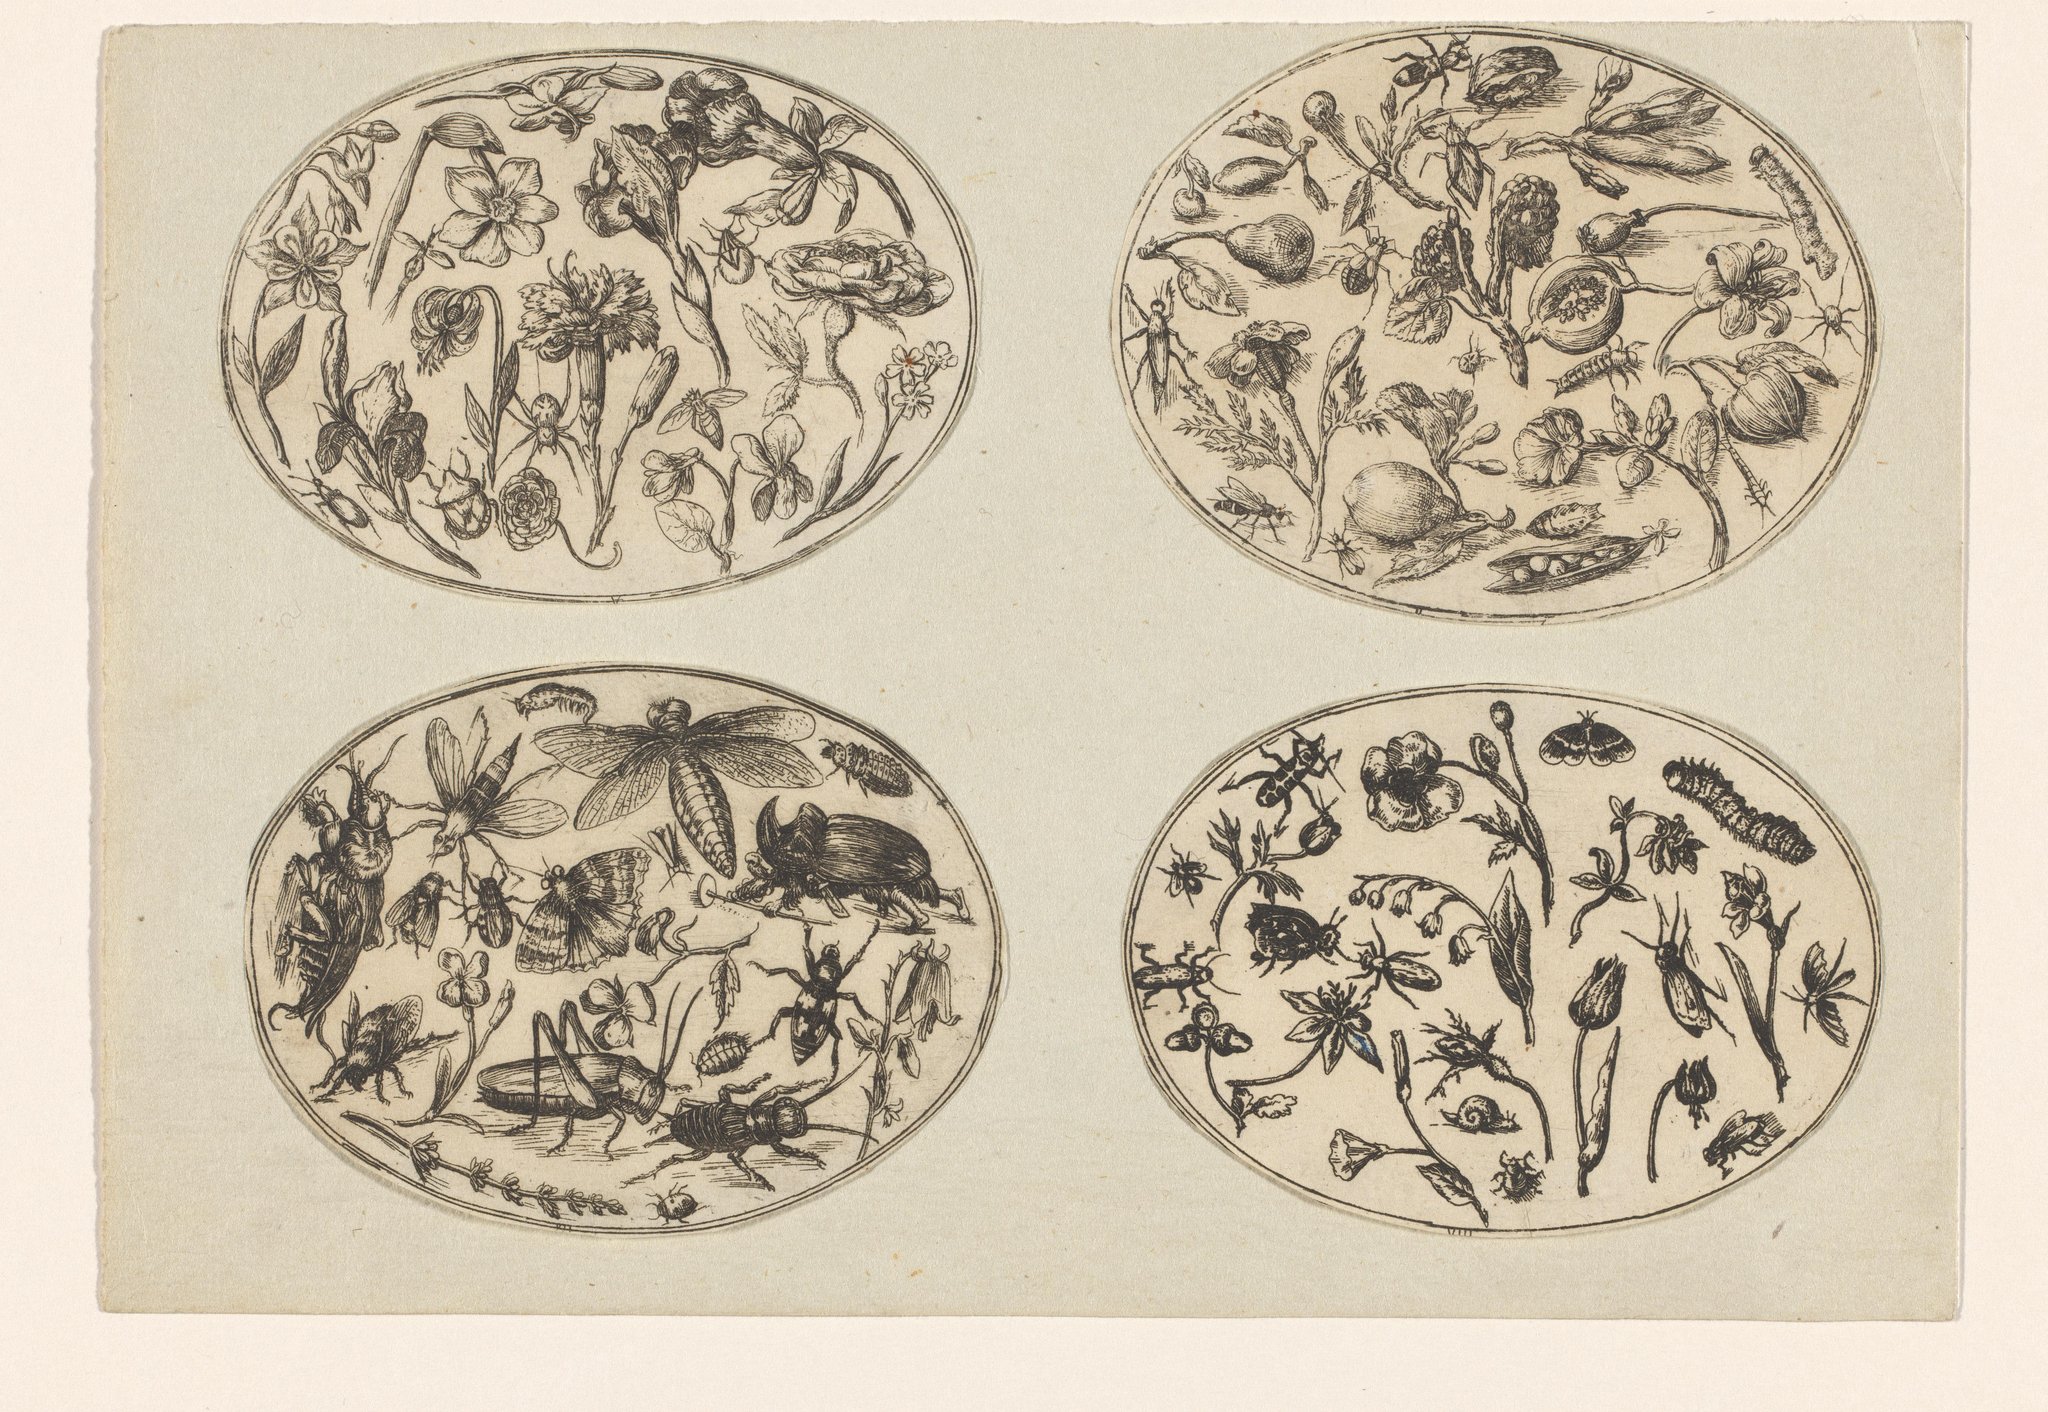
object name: ornament print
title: Vruchten, bloemen, insecten en spinnen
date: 1650-1666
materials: paper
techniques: etching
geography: nuremberg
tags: fruits and vegetables ~ ornament, spiders, insects, flowers ~ ornament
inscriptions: collector's mark: Lugt 2760, collector's mark: Lugt 2228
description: Paul Fürst, Neues Frücht-vnd Blumenbüchlein. Allen Künstlern dienstlich. Een van zeven prenten (RP-P-2020-235 t/m 241), inclusief titelblad uit een reeks van acht met weergaven van bloemen, vruchten, noten paddenstoelen en insecten.